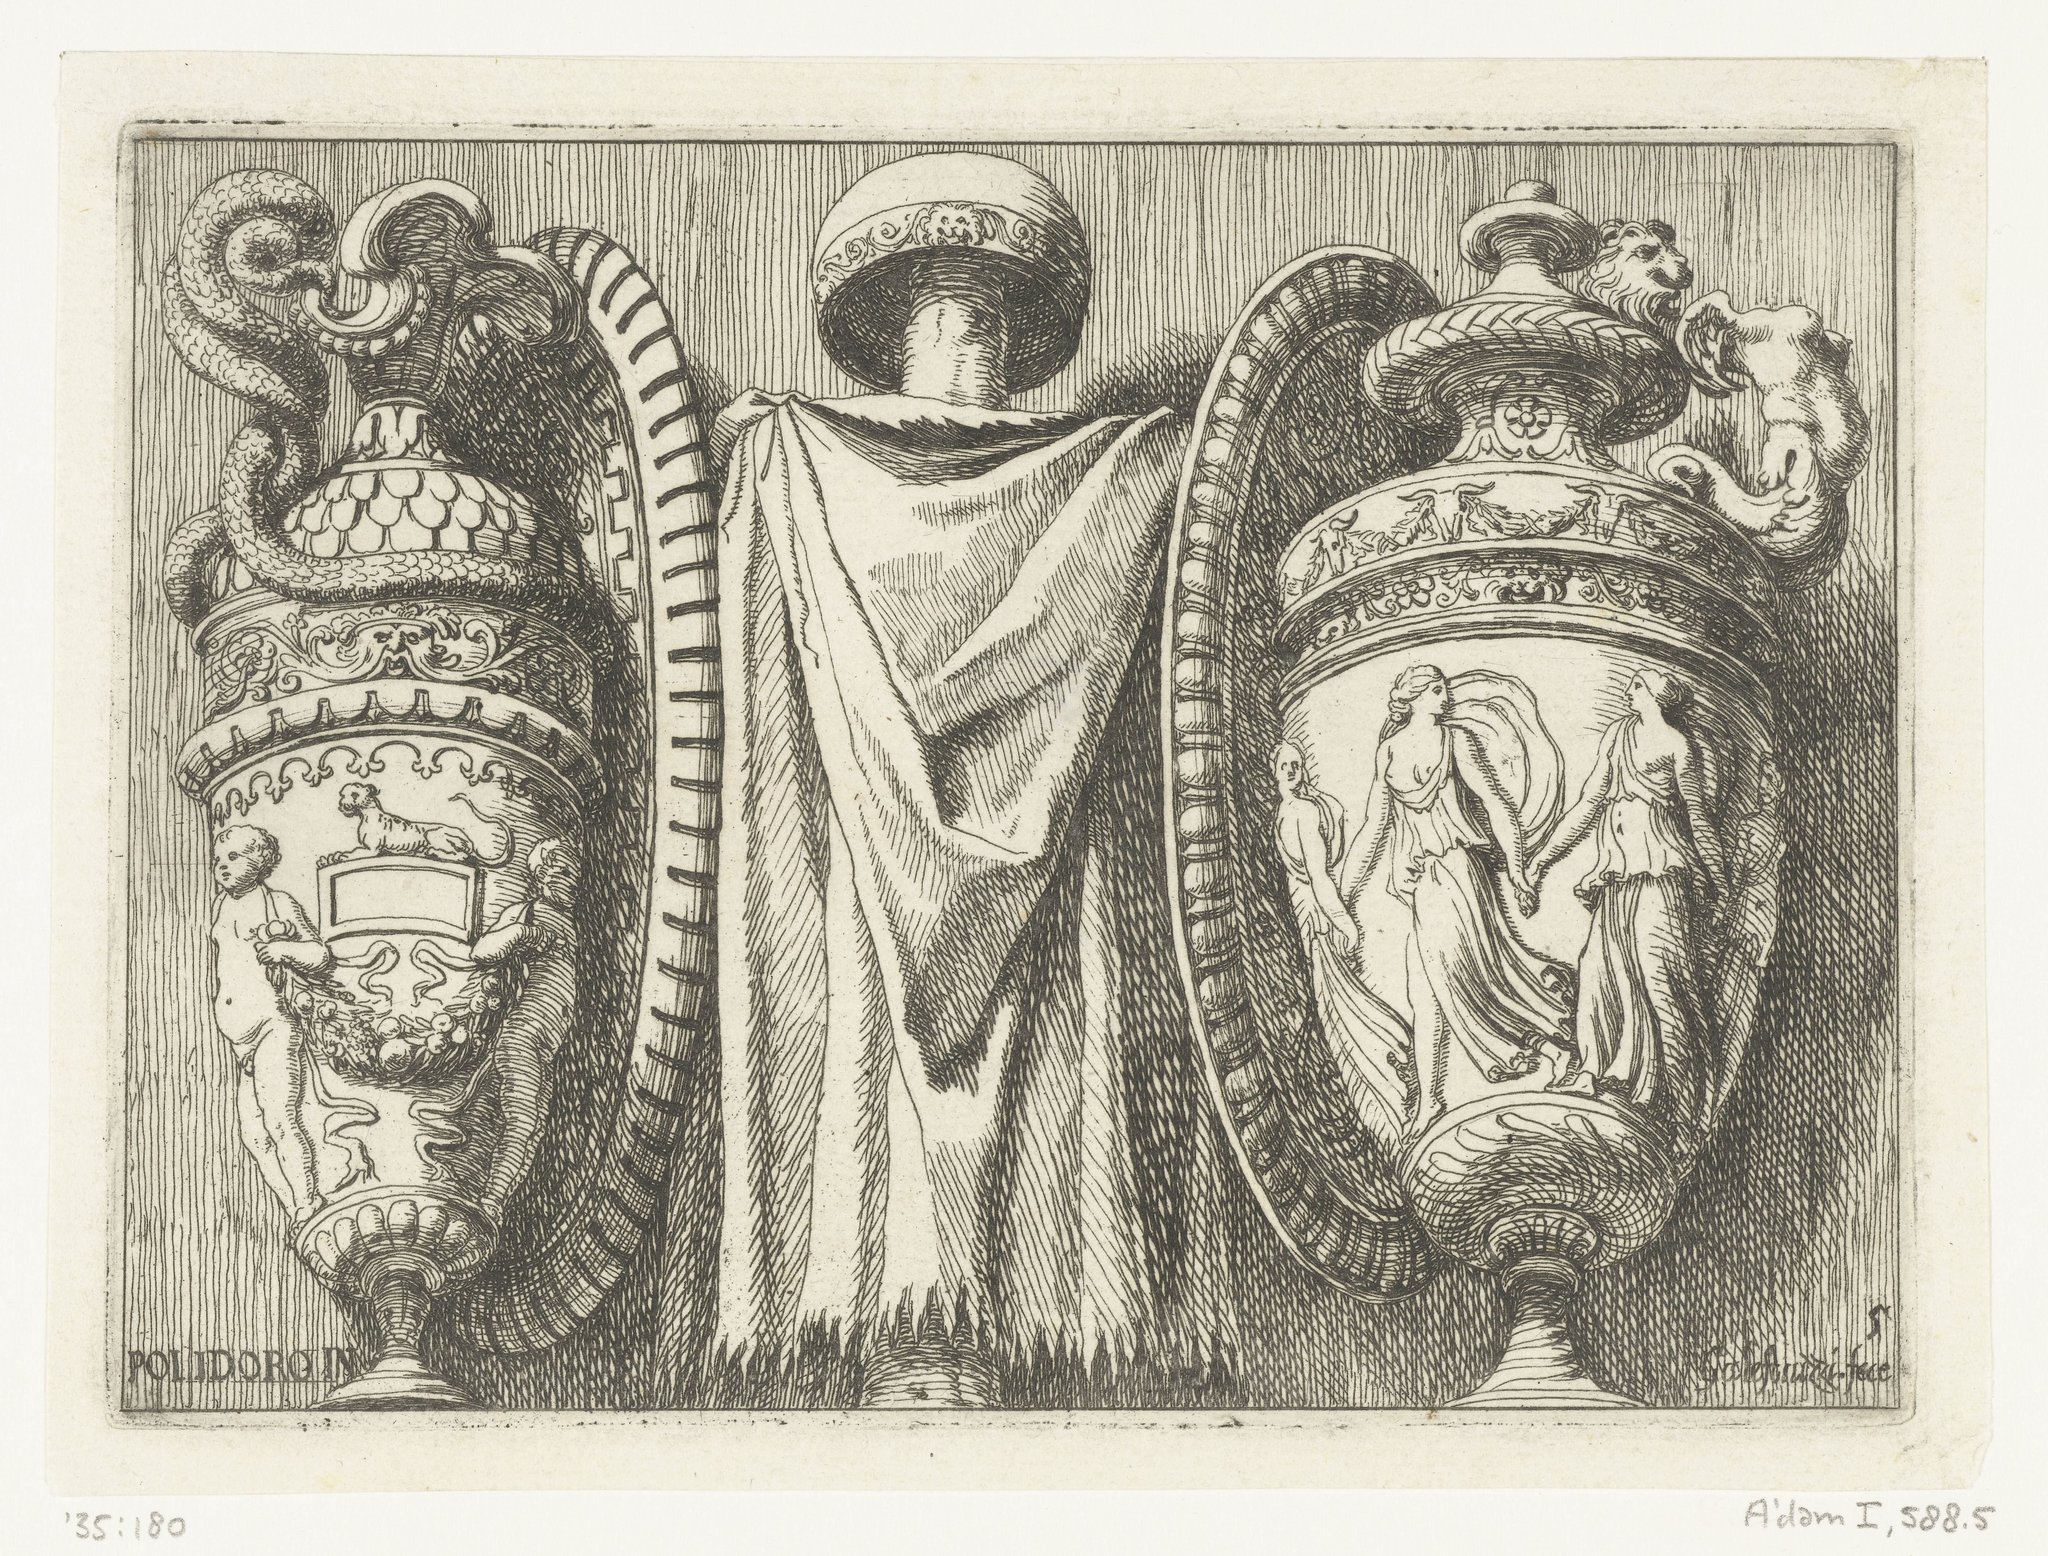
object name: ornament print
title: Boomstronk met een chiton en een helm tussen een kan en een vaas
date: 1660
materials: paper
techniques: engraving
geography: italy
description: Links staat een kan met een oor in de vorm van een slang.